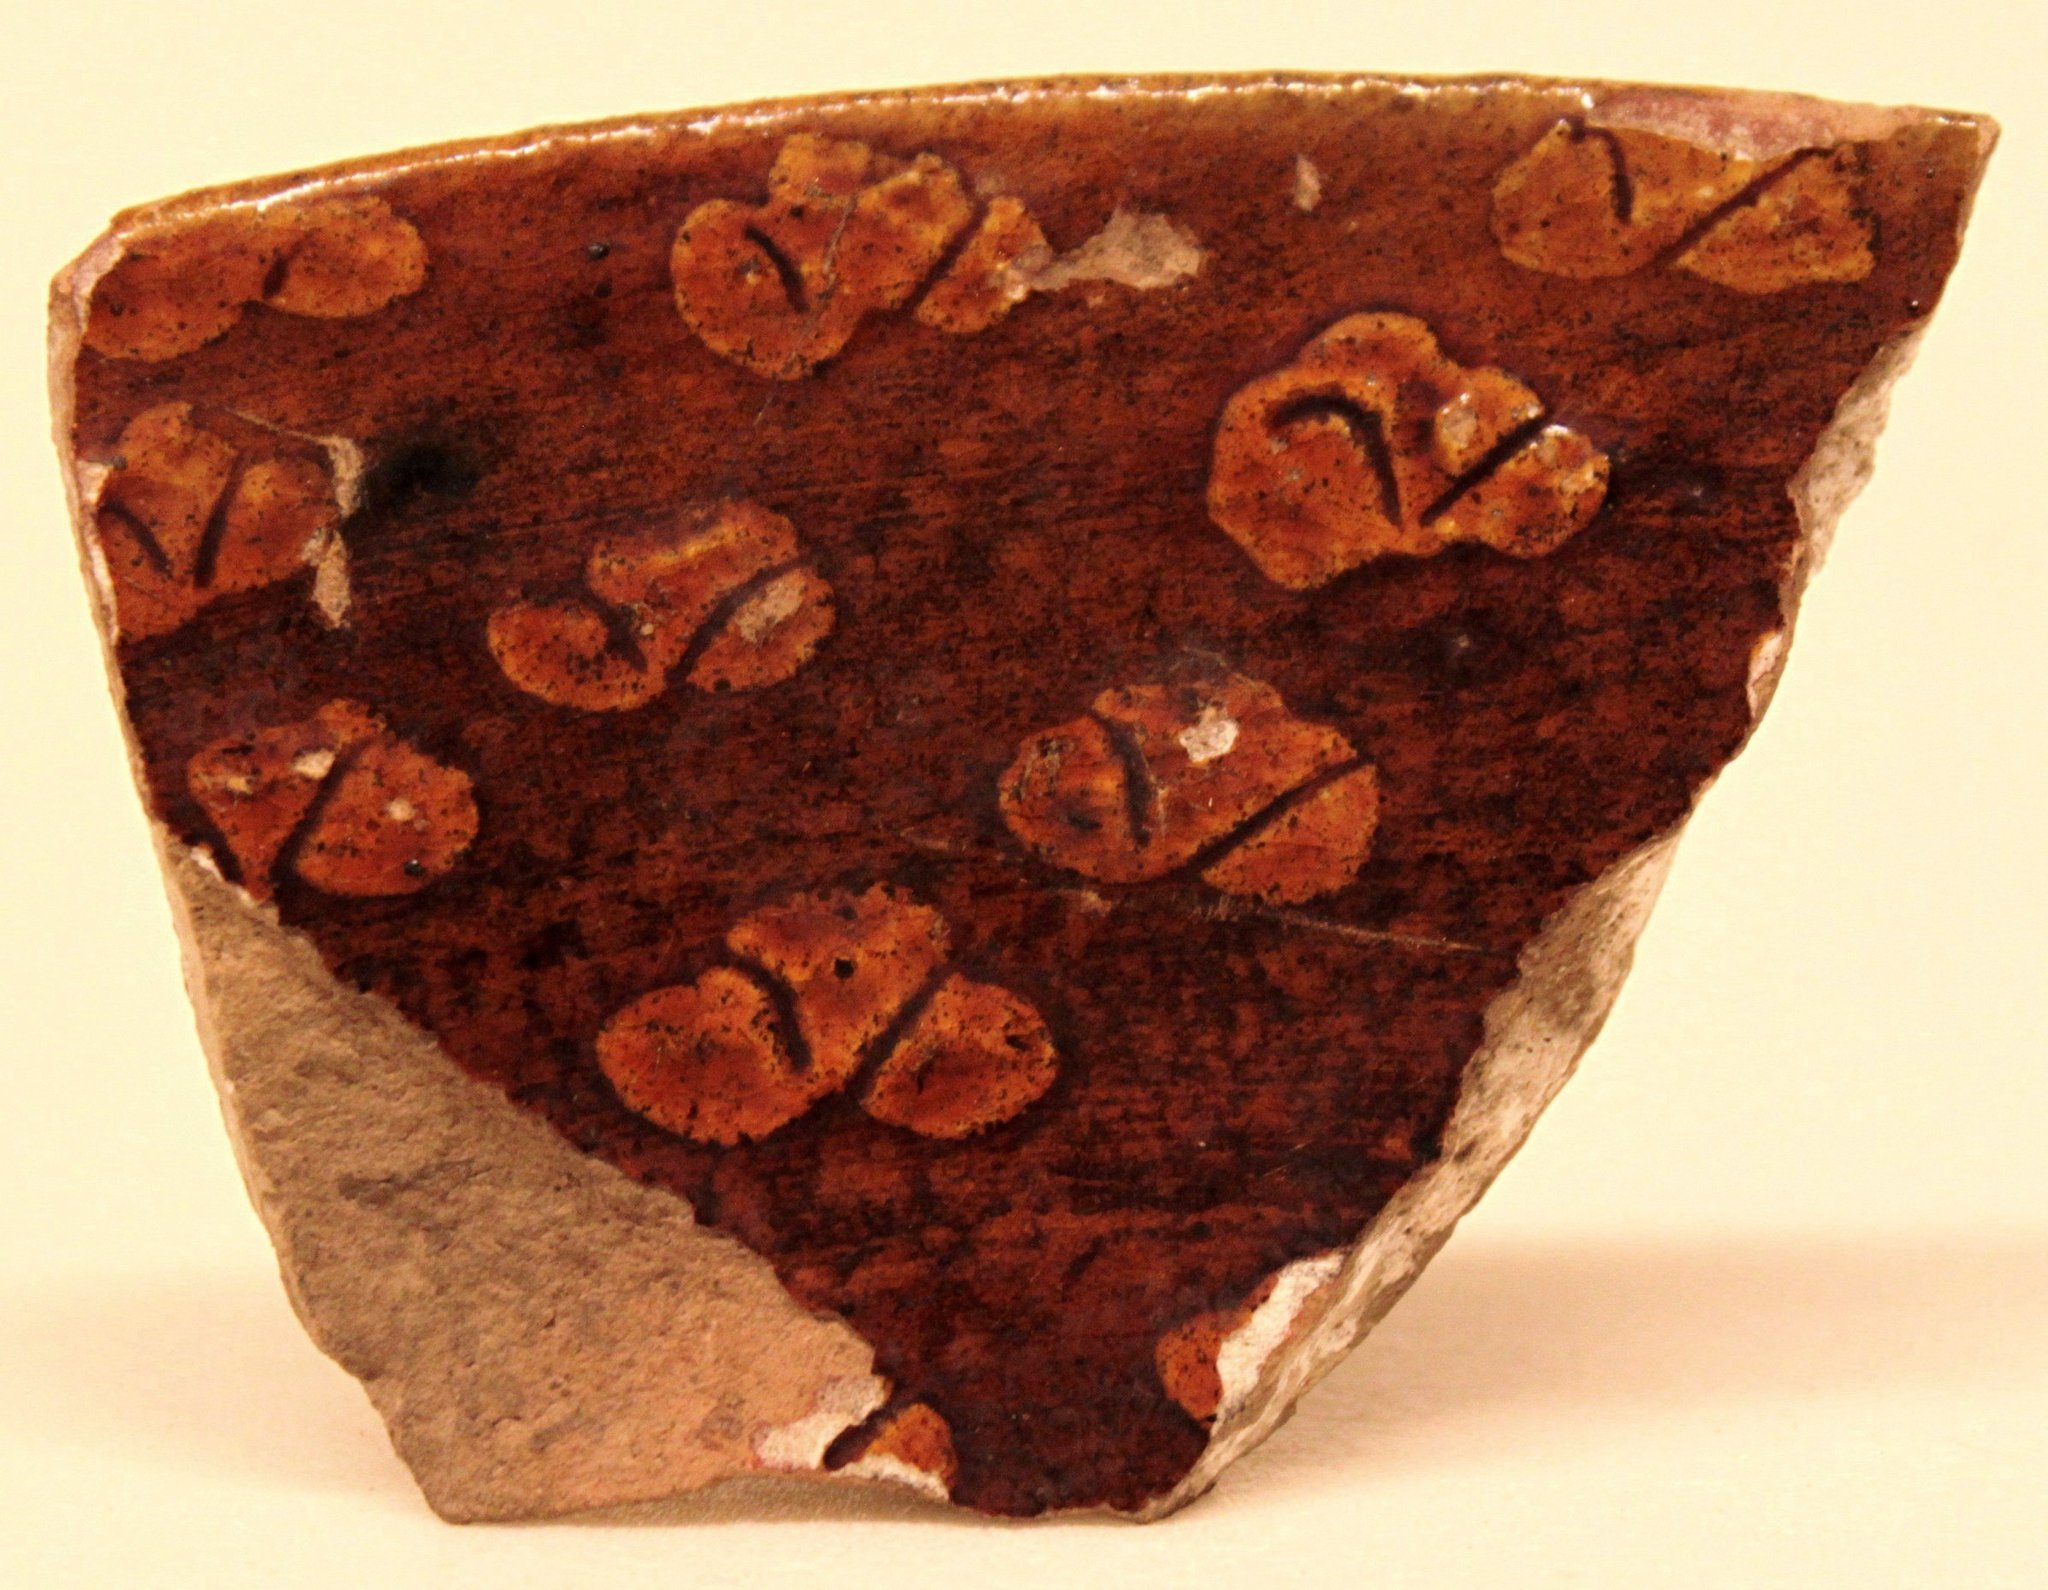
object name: fragment of a bowl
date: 801-1000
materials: earthenware, glaze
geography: iran